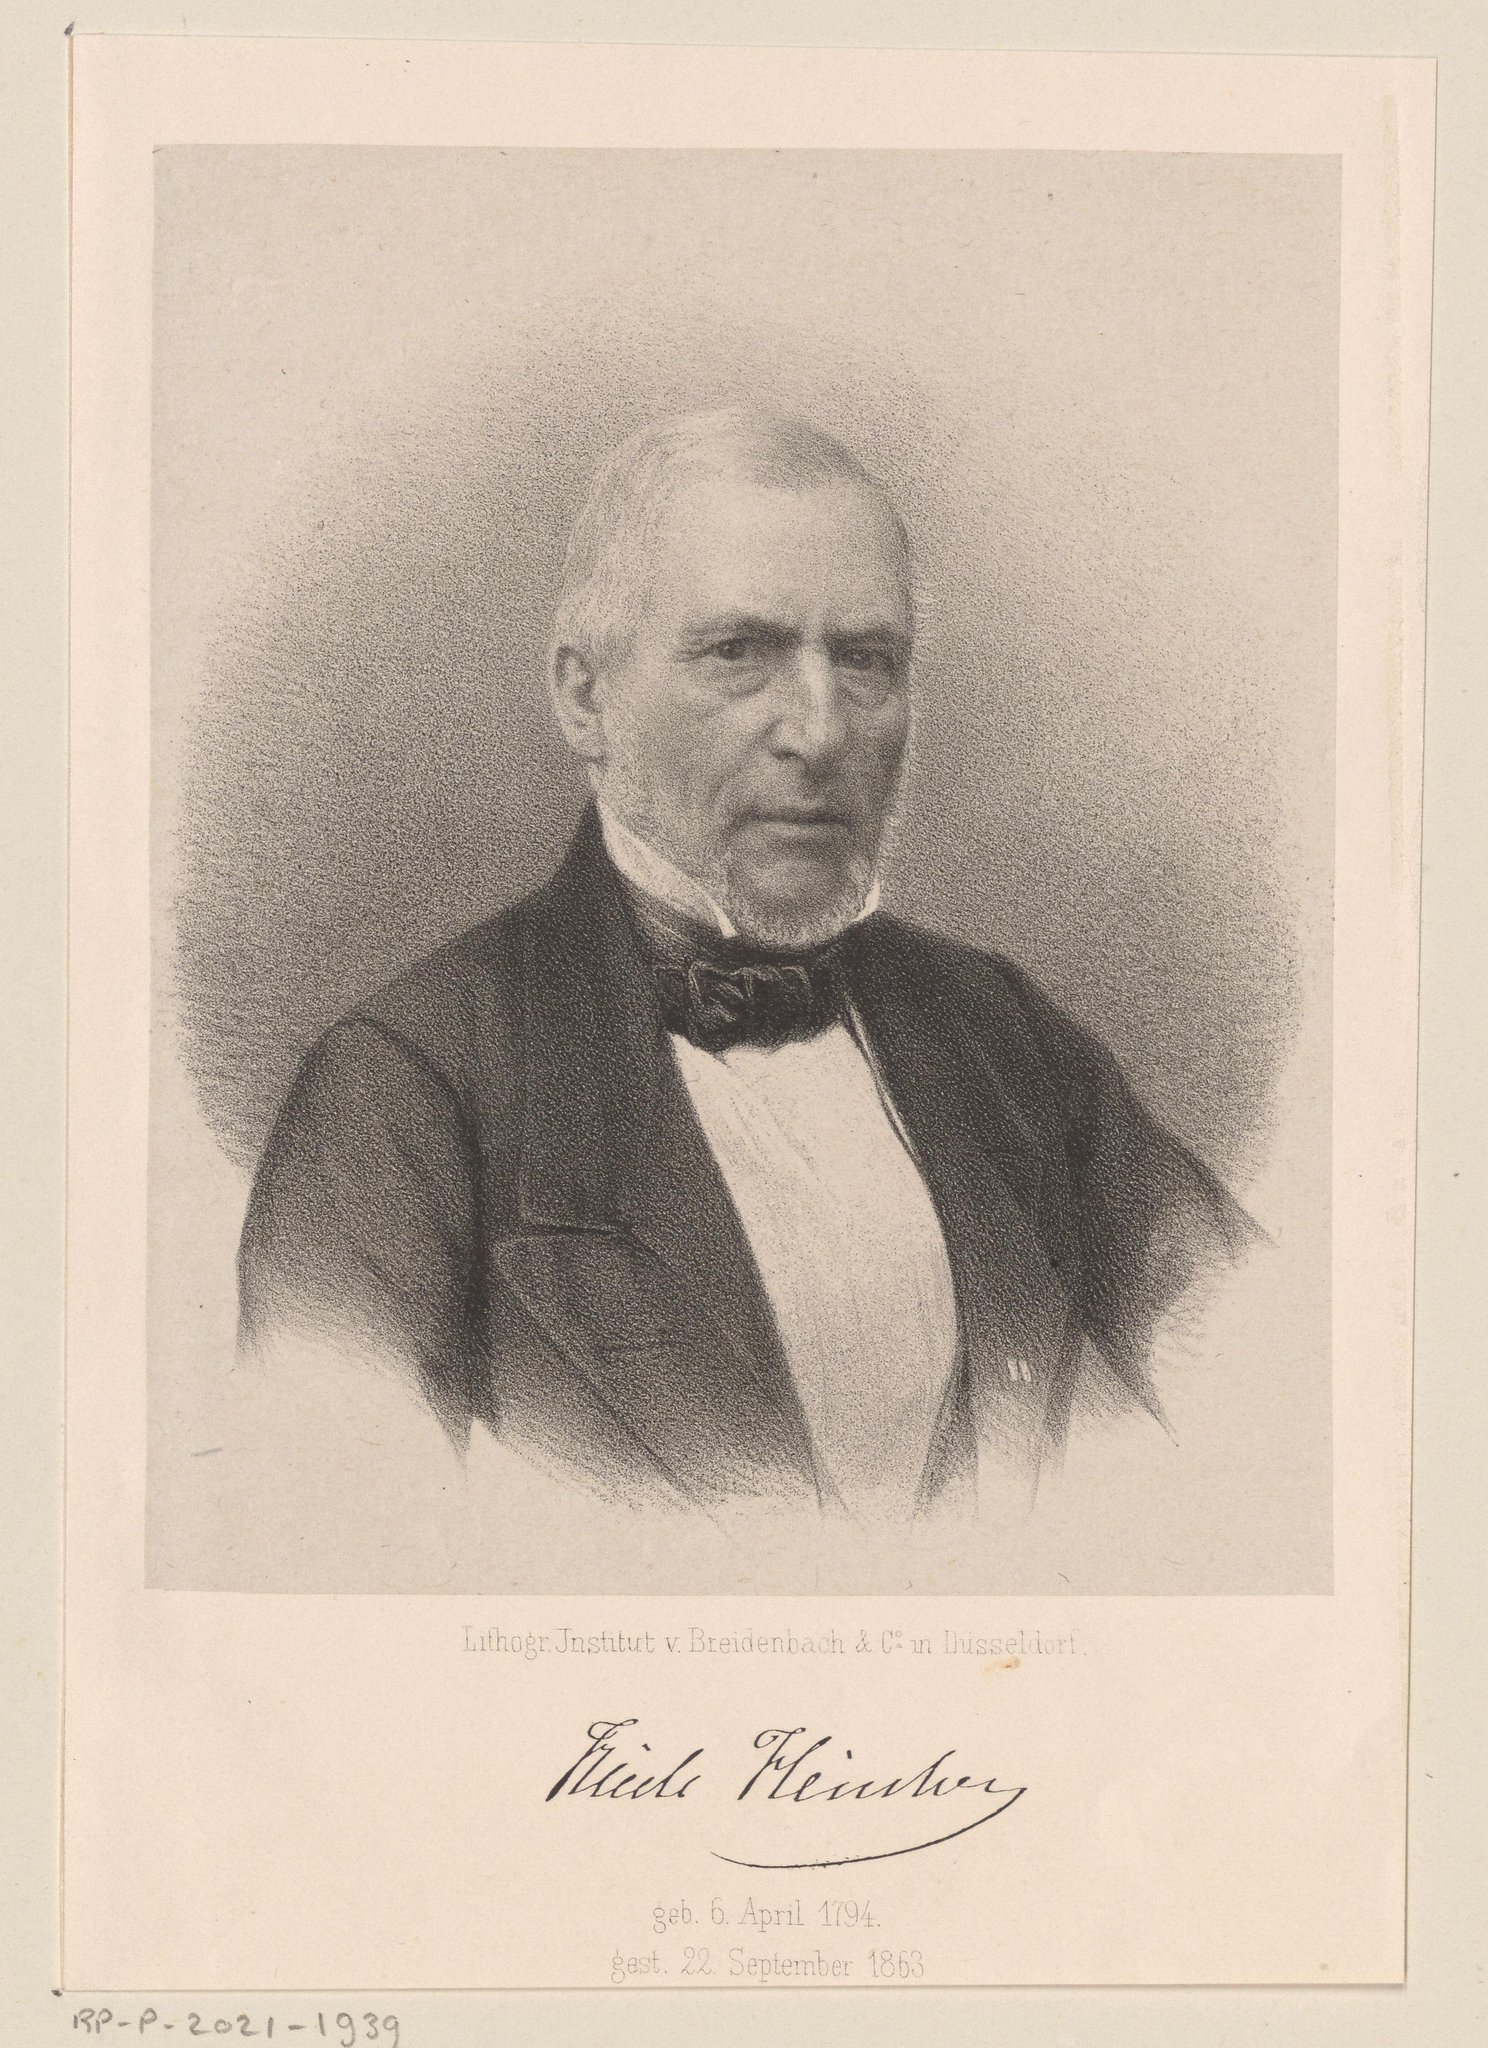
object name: print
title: Portret van Friedrich Fleischer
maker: Anonymous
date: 1863-1899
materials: paper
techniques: lithograph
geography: dusseldorf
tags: historical persons, publishing, publisher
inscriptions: collector's mark: Lugt 2233